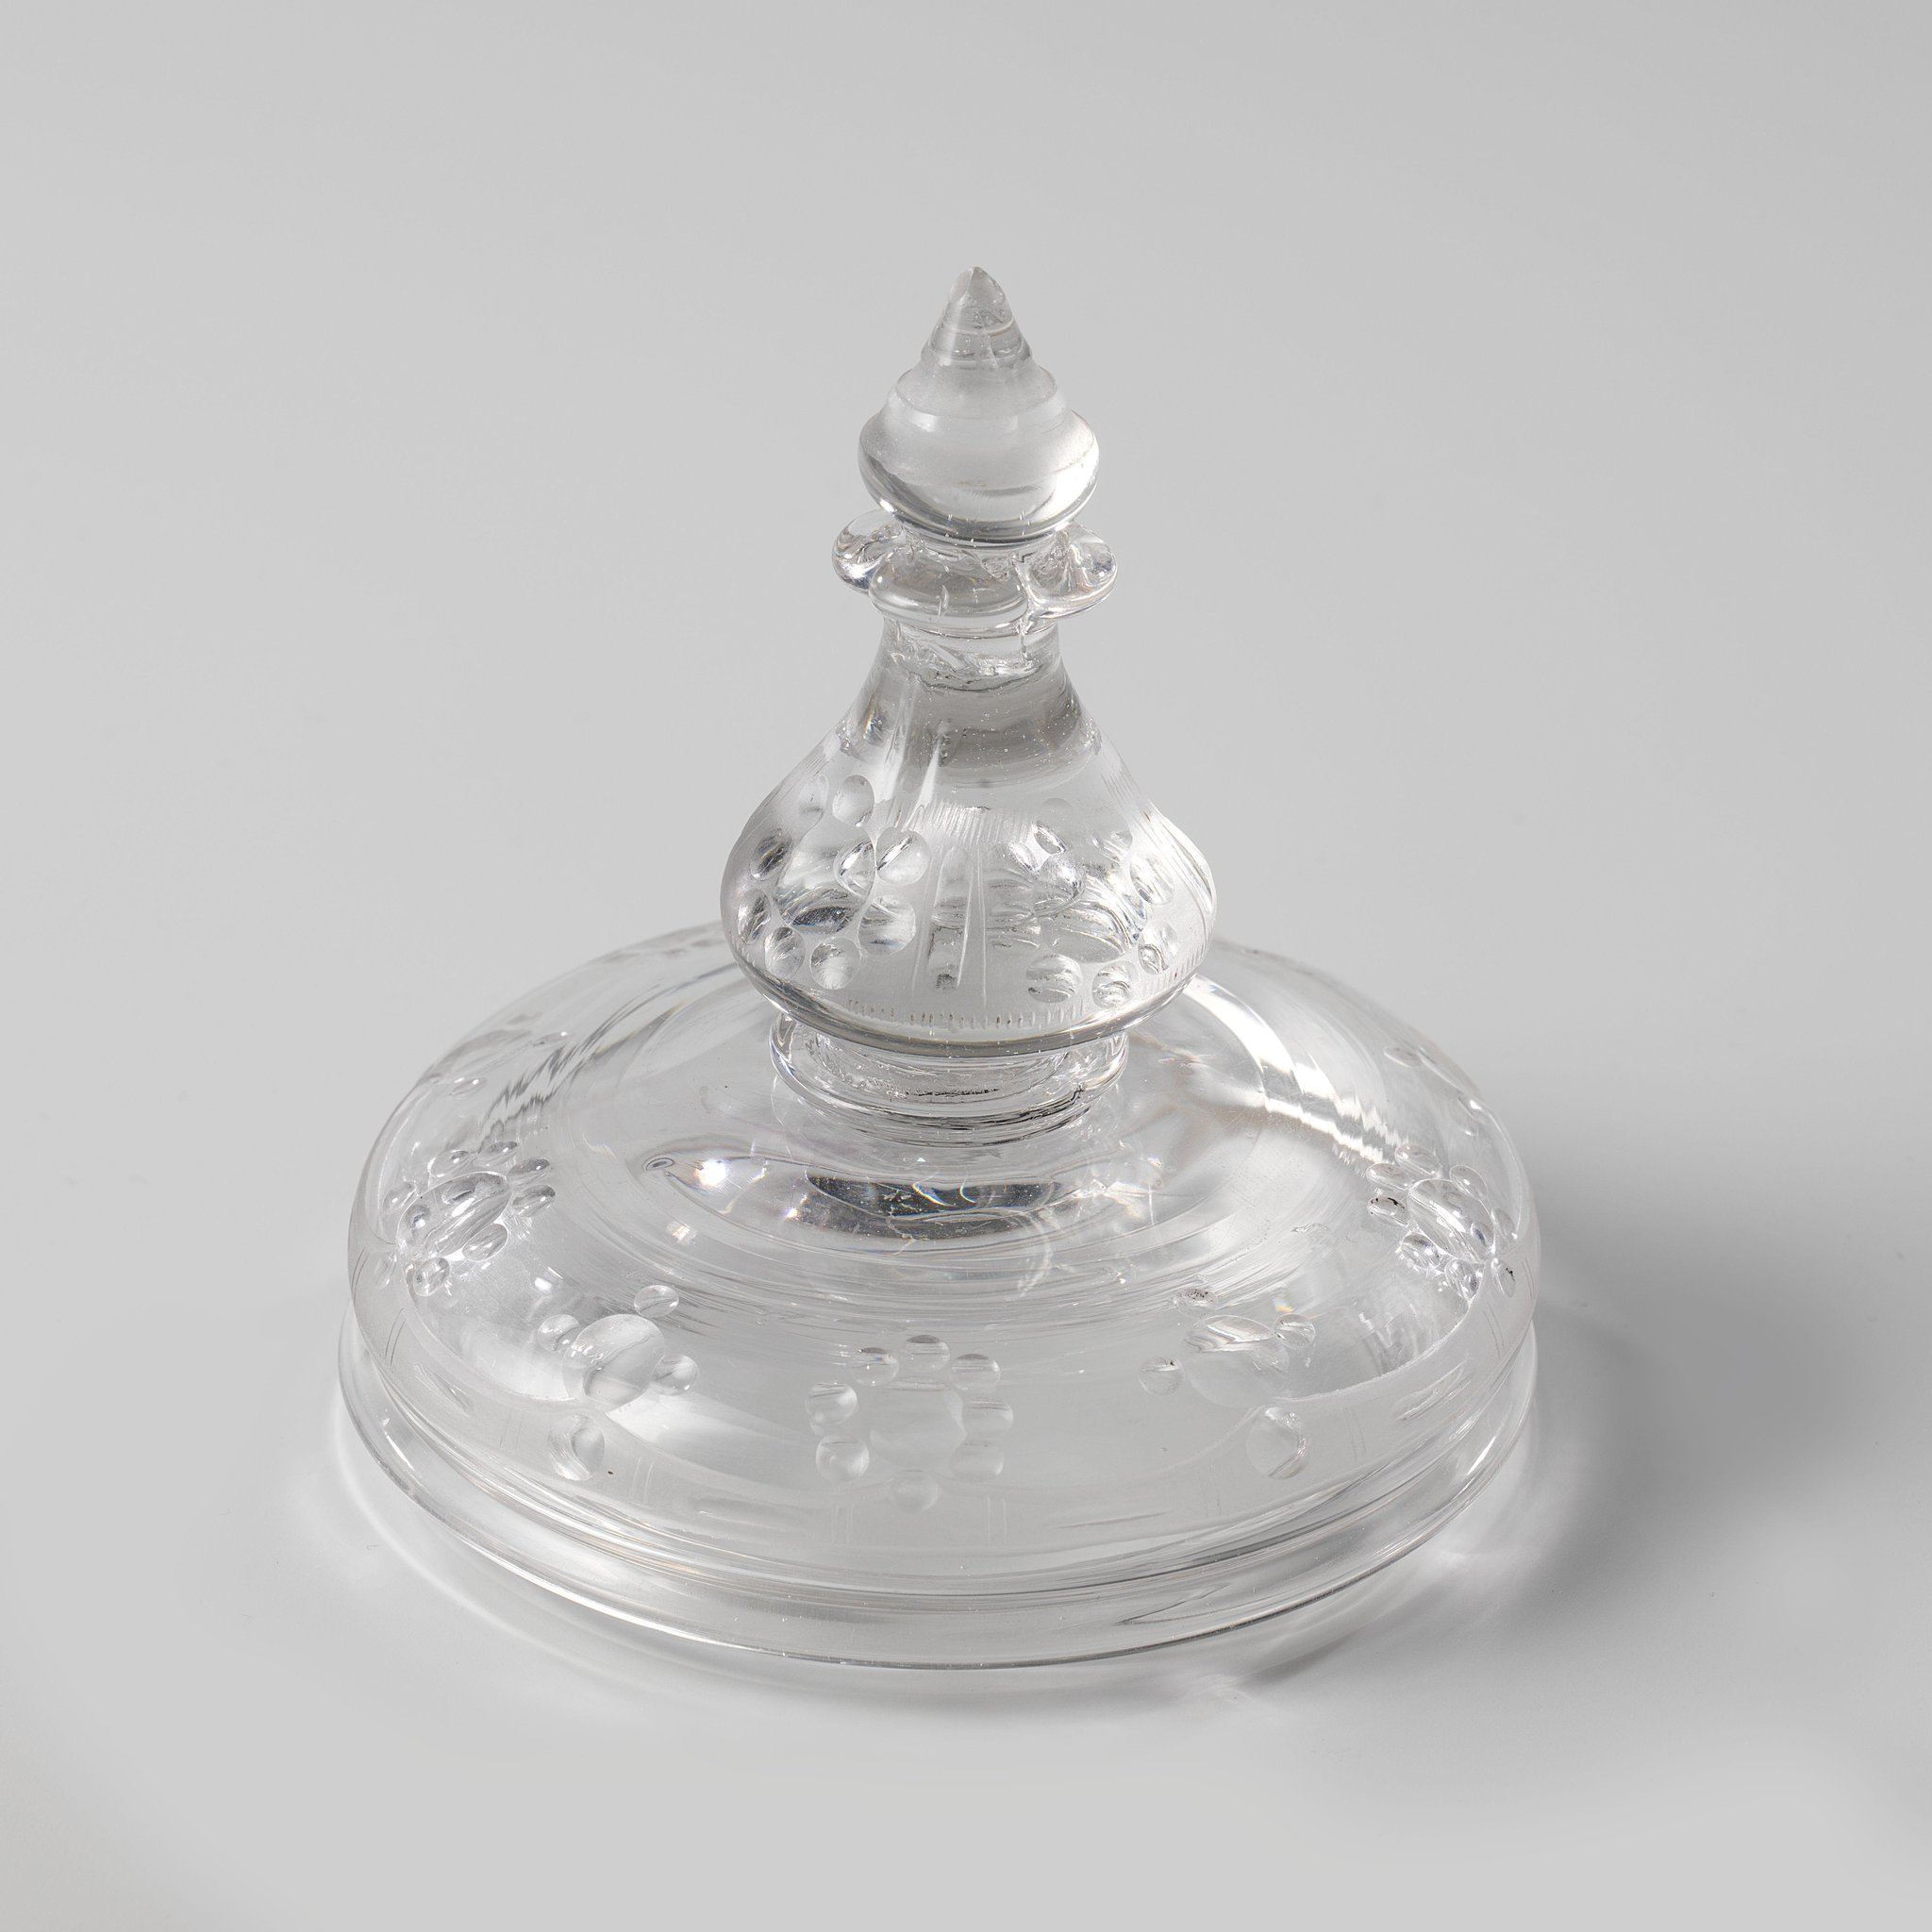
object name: lid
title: Deksel van een bokaal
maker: Anonymous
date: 1750-1775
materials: glass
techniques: glassblowing, grinding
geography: germany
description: Gewelfde deksel met balustervormige knop en gegraveerde, peervormige uiteinde. Op de deksel rondlopend geslepen bloemen.